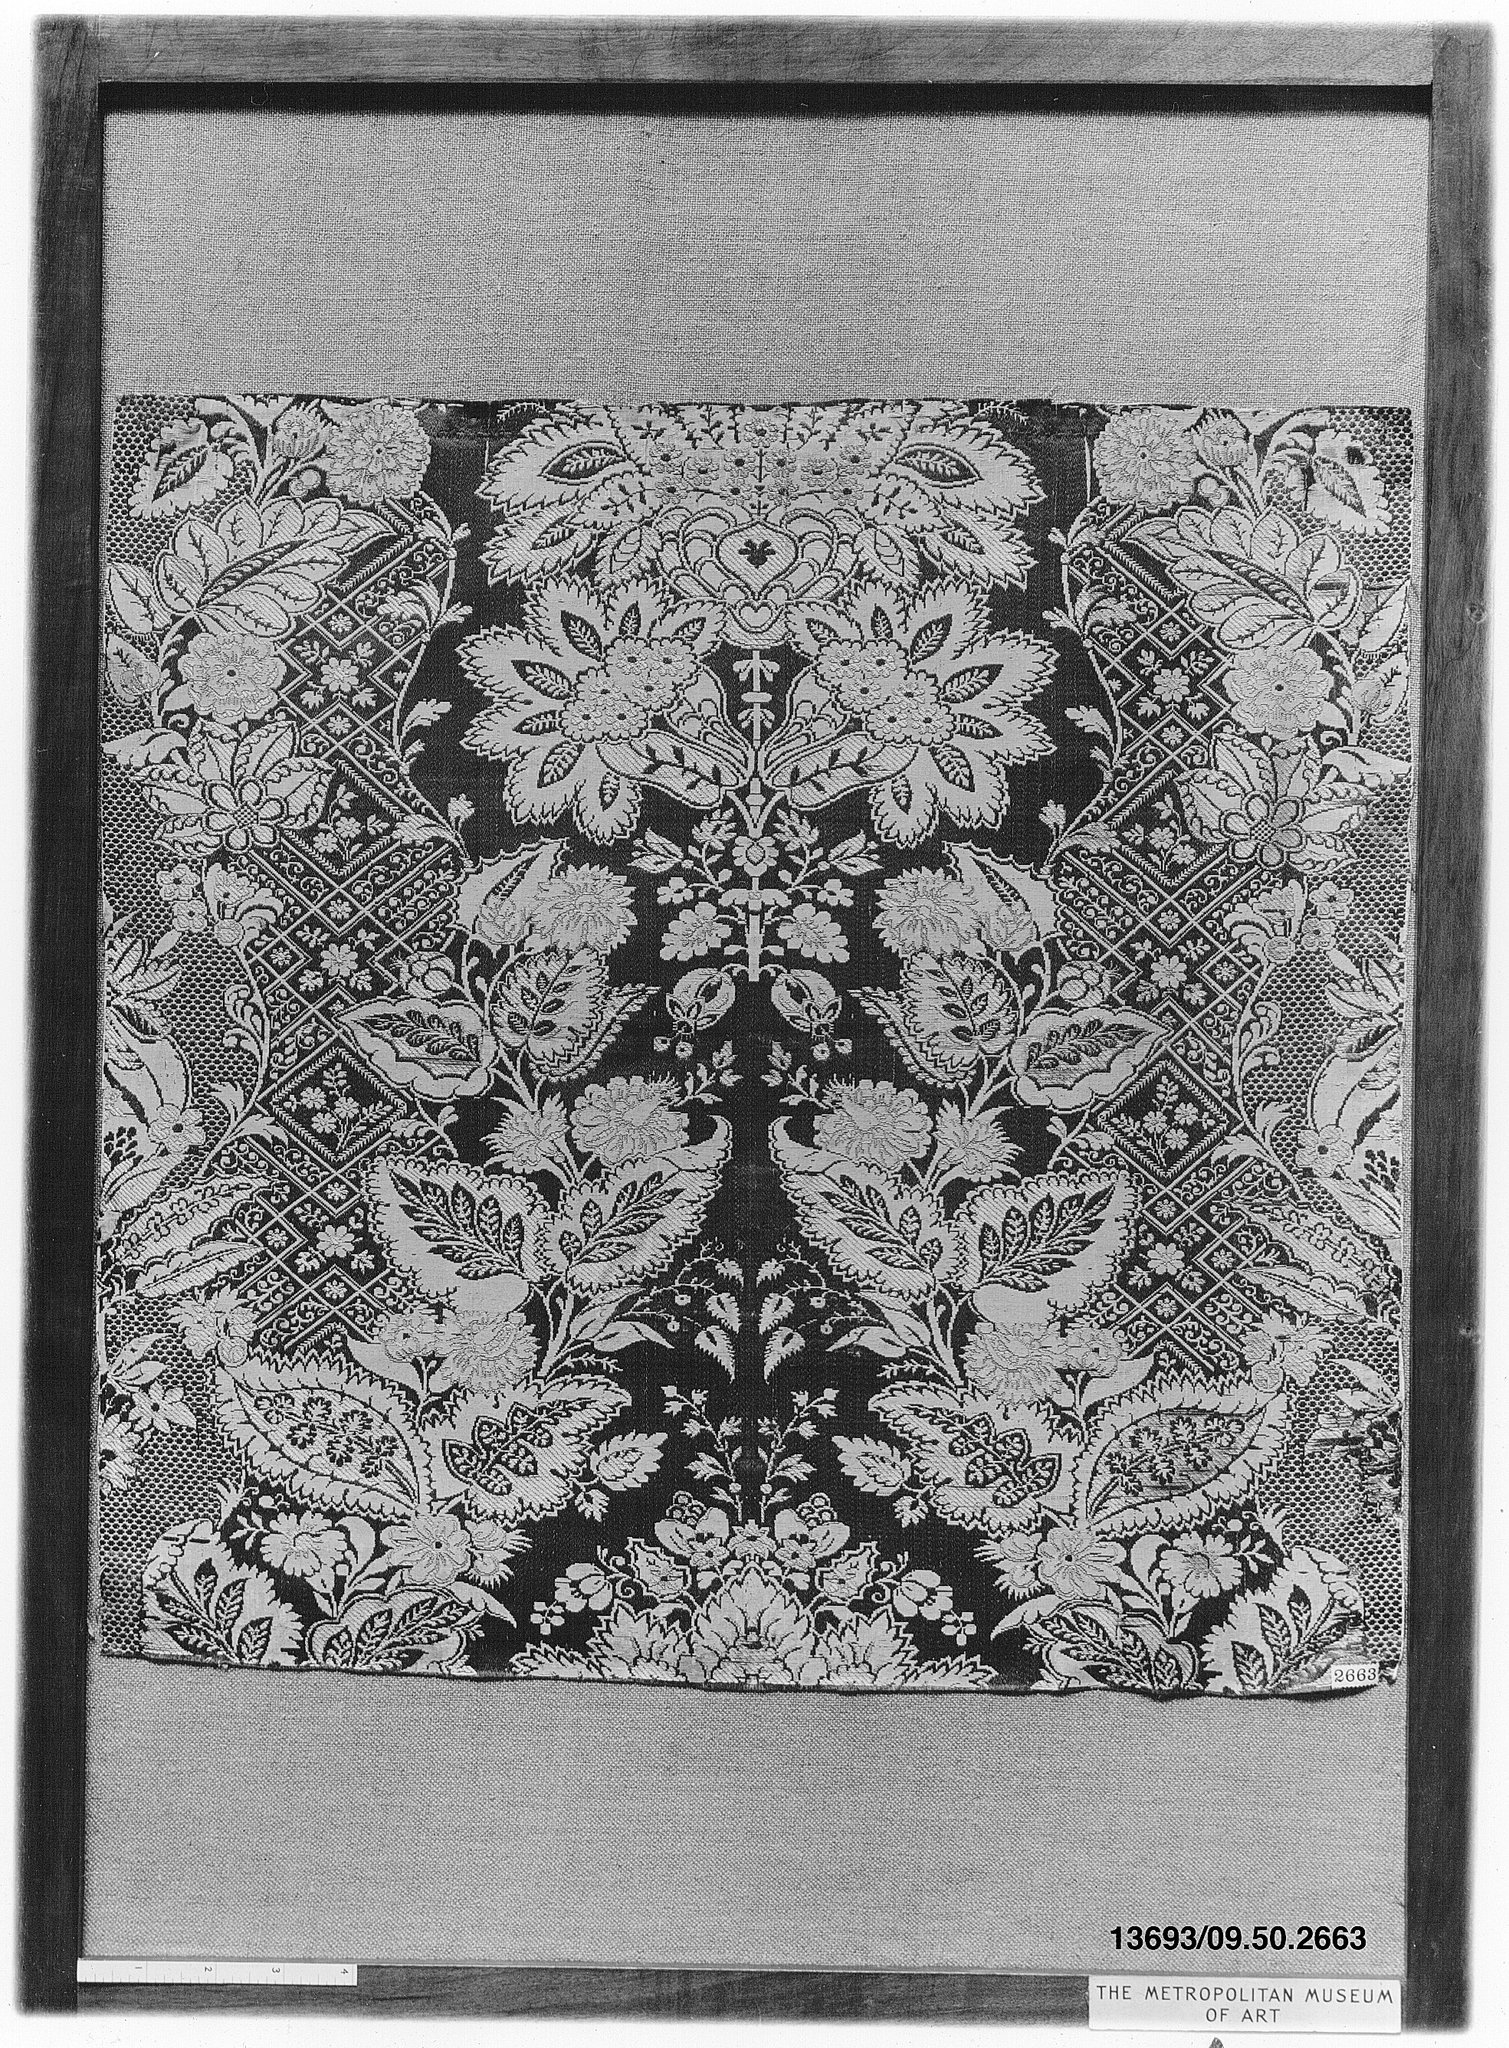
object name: piece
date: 1730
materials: silk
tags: flowers,leaves